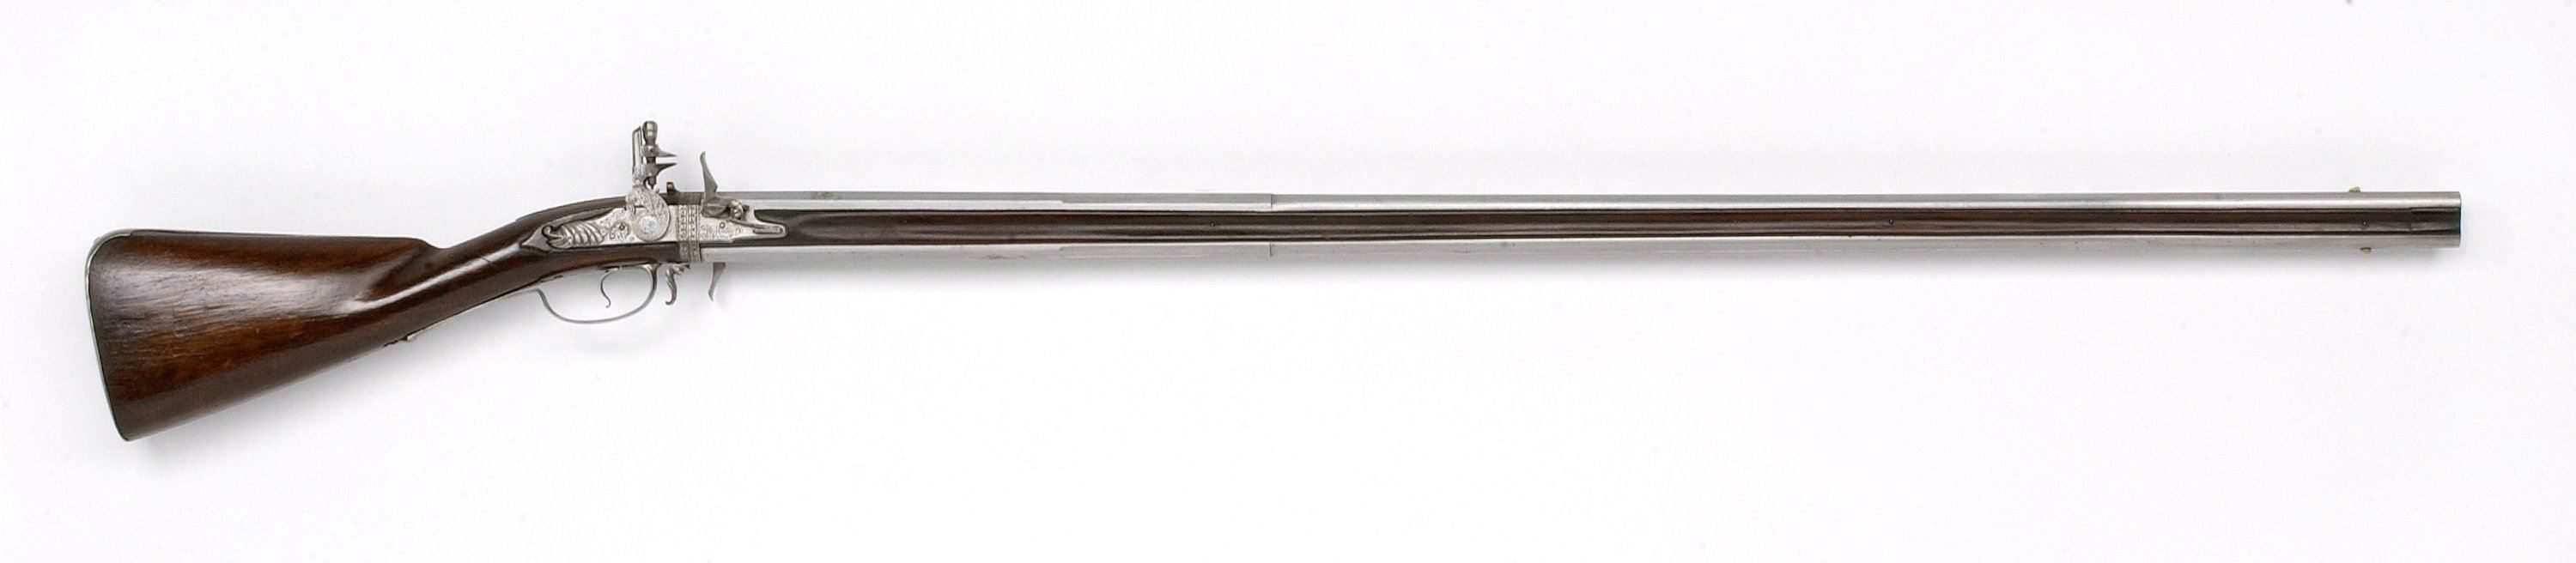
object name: flintlock pistol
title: Dubbelloops vuursteendraailoopgeweer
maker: jan kitzen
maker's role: geweermaker, koopman, pistoolmaker, slotenmaker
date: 1650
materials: brass, horn, wood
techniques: embroidery, engraving, filing, relief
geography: maastricht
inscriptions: mark: ‘26’, inscription: ‘à Maestricht’, mark: ‘I*K’, signature: ‘Jan Kitzen : Ft’